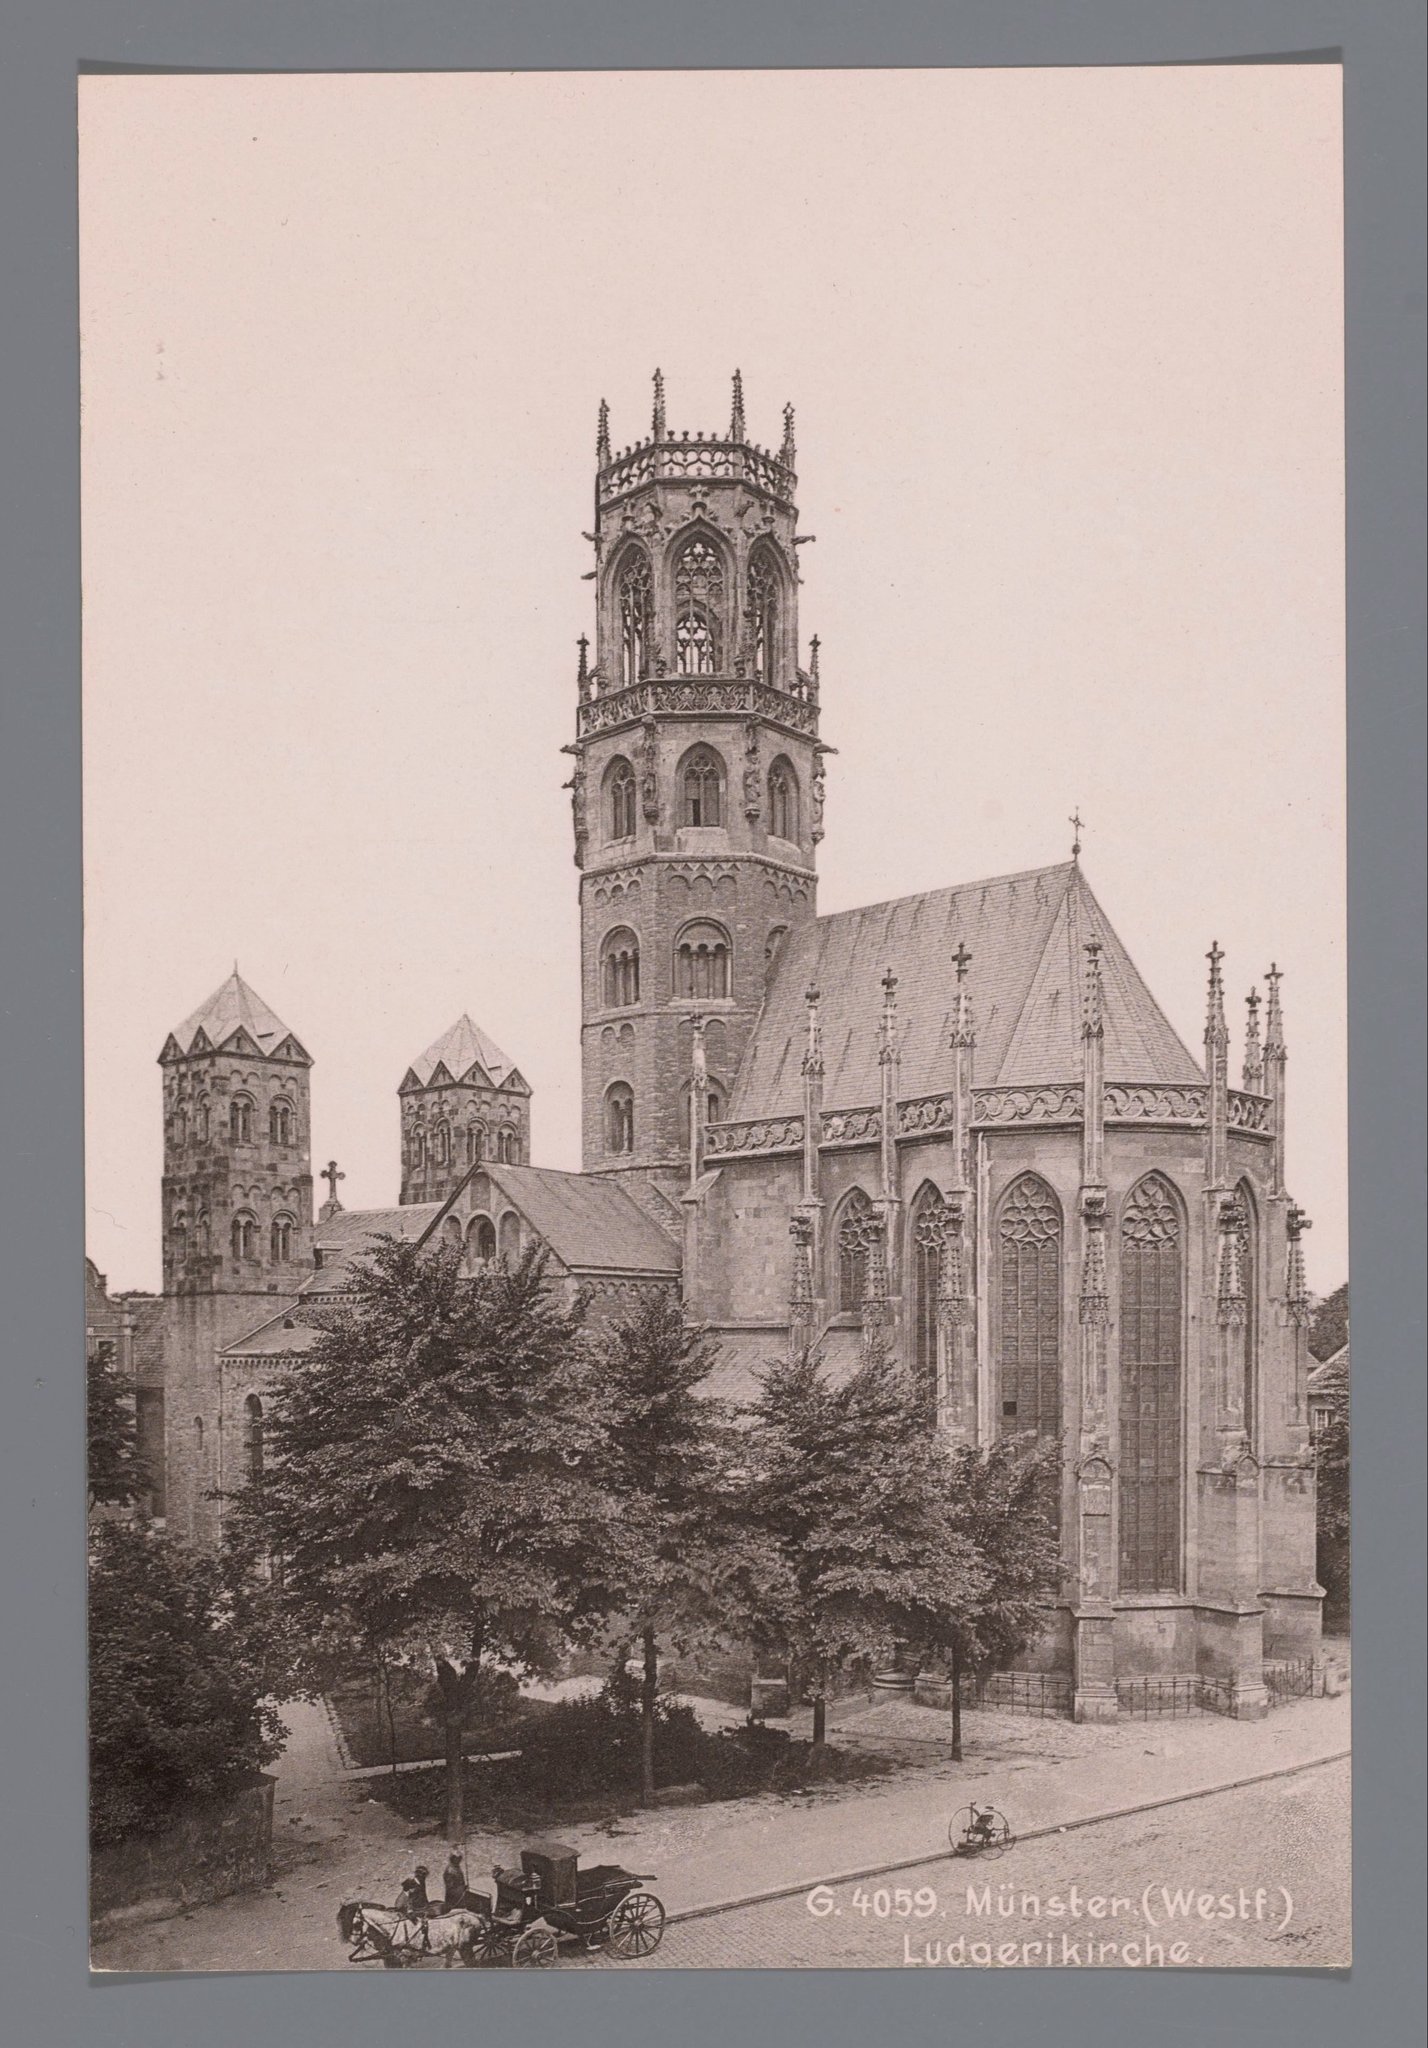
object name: photomechanical print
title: Münster (Westf.) Ludgerikirche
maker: Anonymous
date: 1890-1910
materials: paper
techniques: photograph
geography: munster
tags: church (exterior)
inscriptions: title: ‘G. 4059 Münster (Westf.)/ Ludgerikirche’